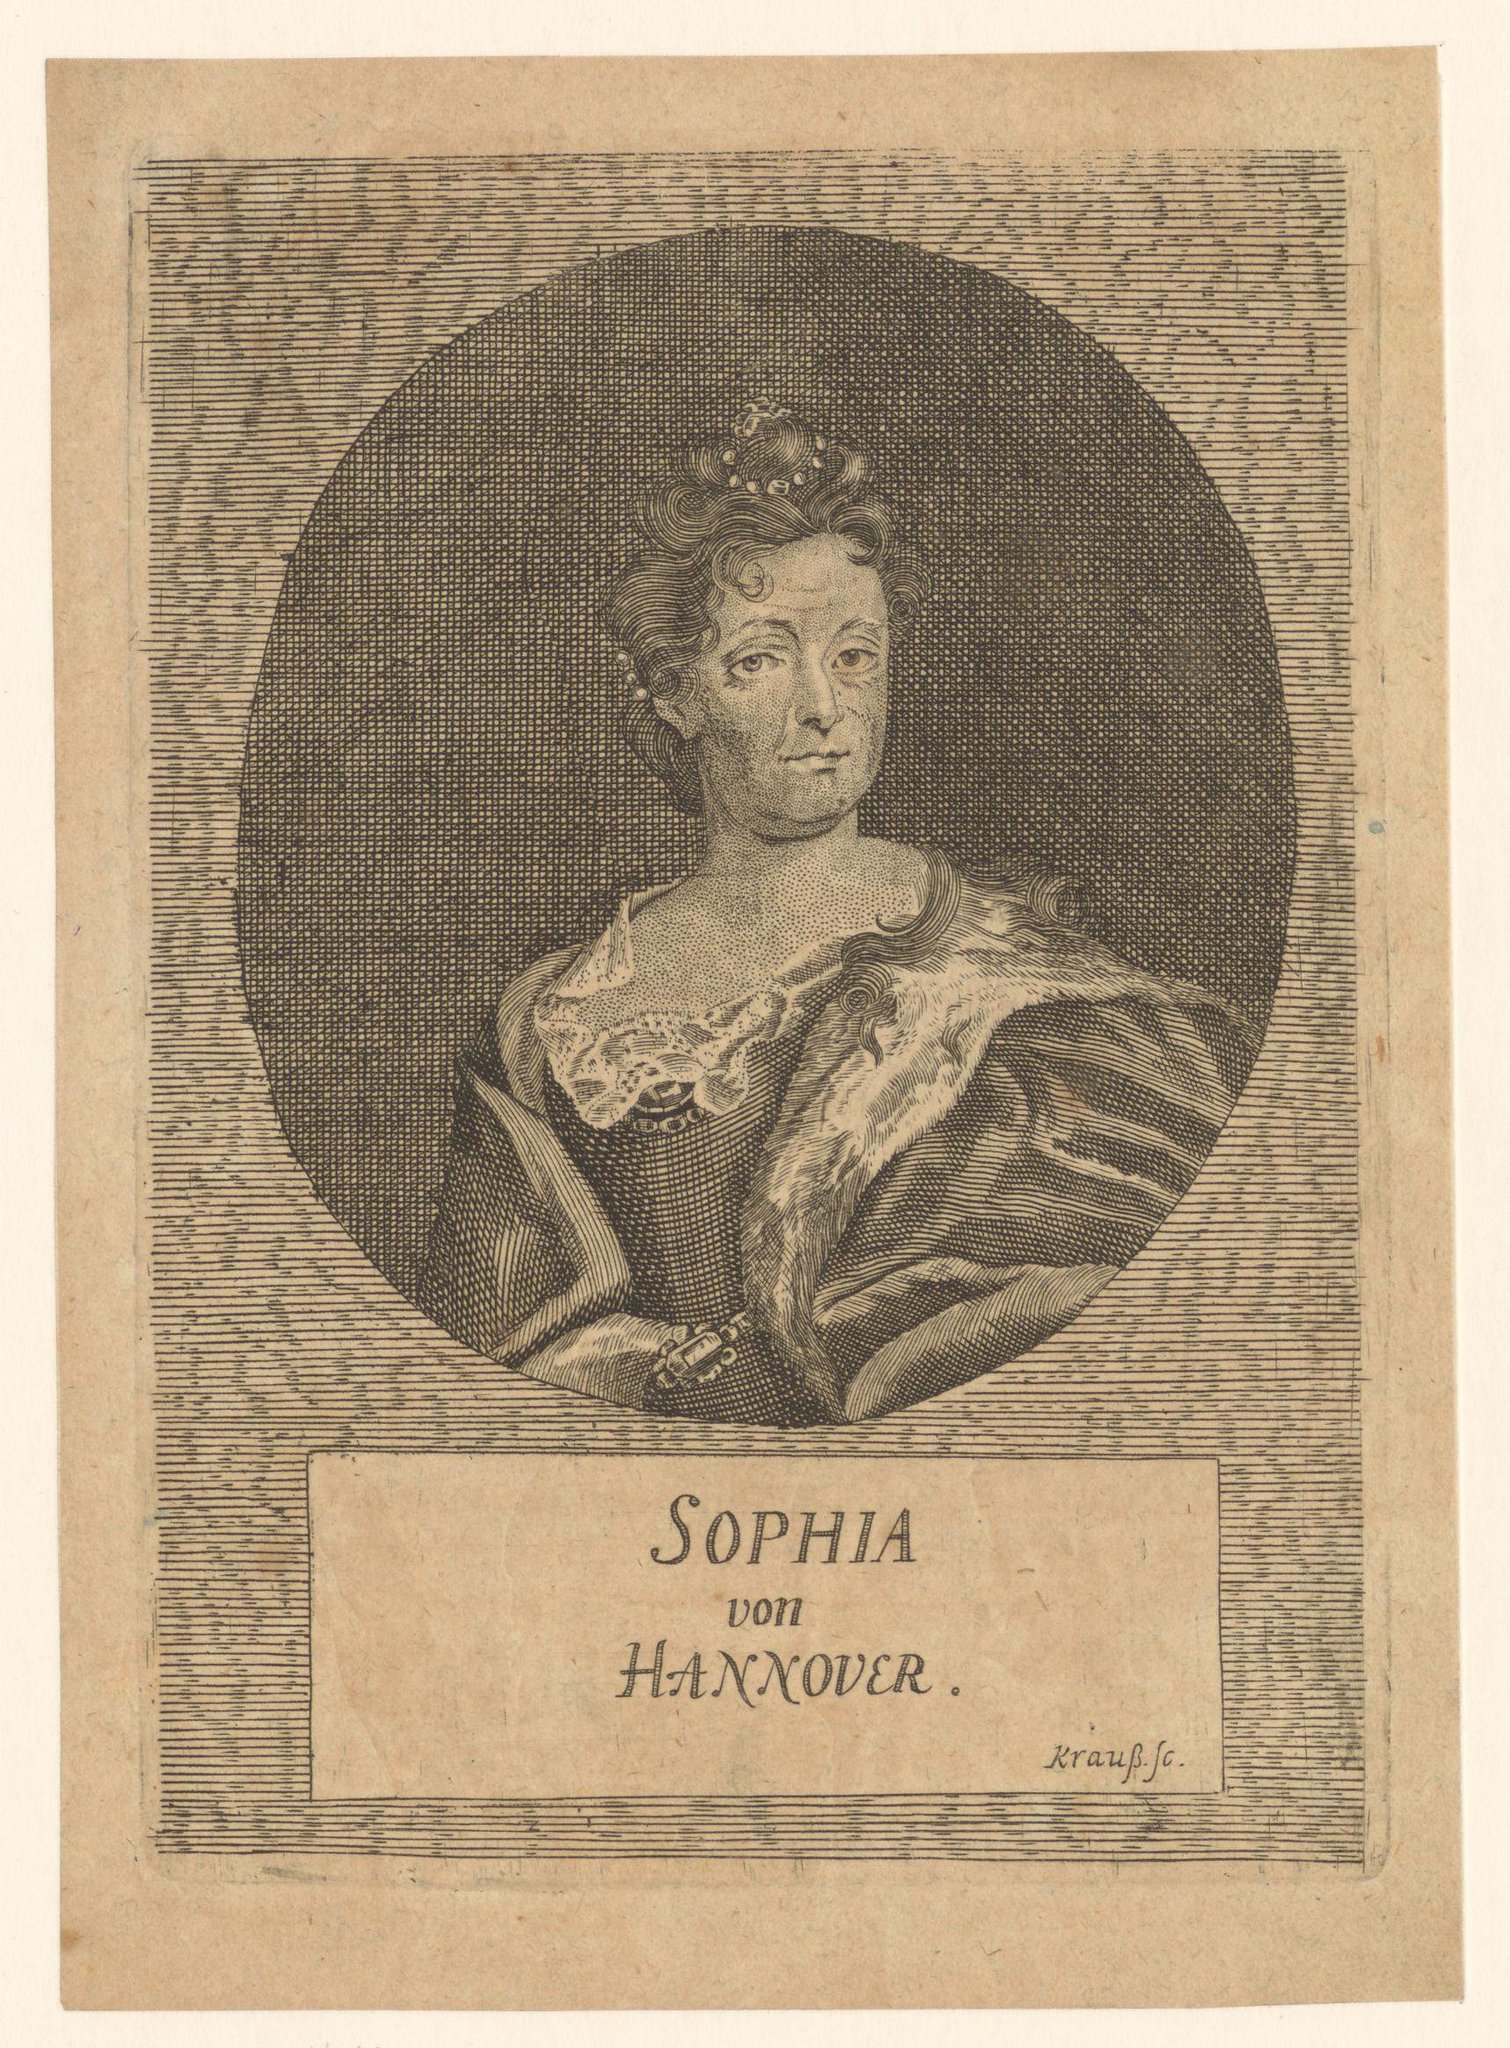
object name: print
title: Portret van Sophia van de Palts, keurvorst van Hannover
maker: jodocus egidius krauss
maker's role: print maker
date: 1705-1753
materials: paper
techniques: engraving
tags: the hague, historical persons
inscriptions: collector's mark: Lugt 2228